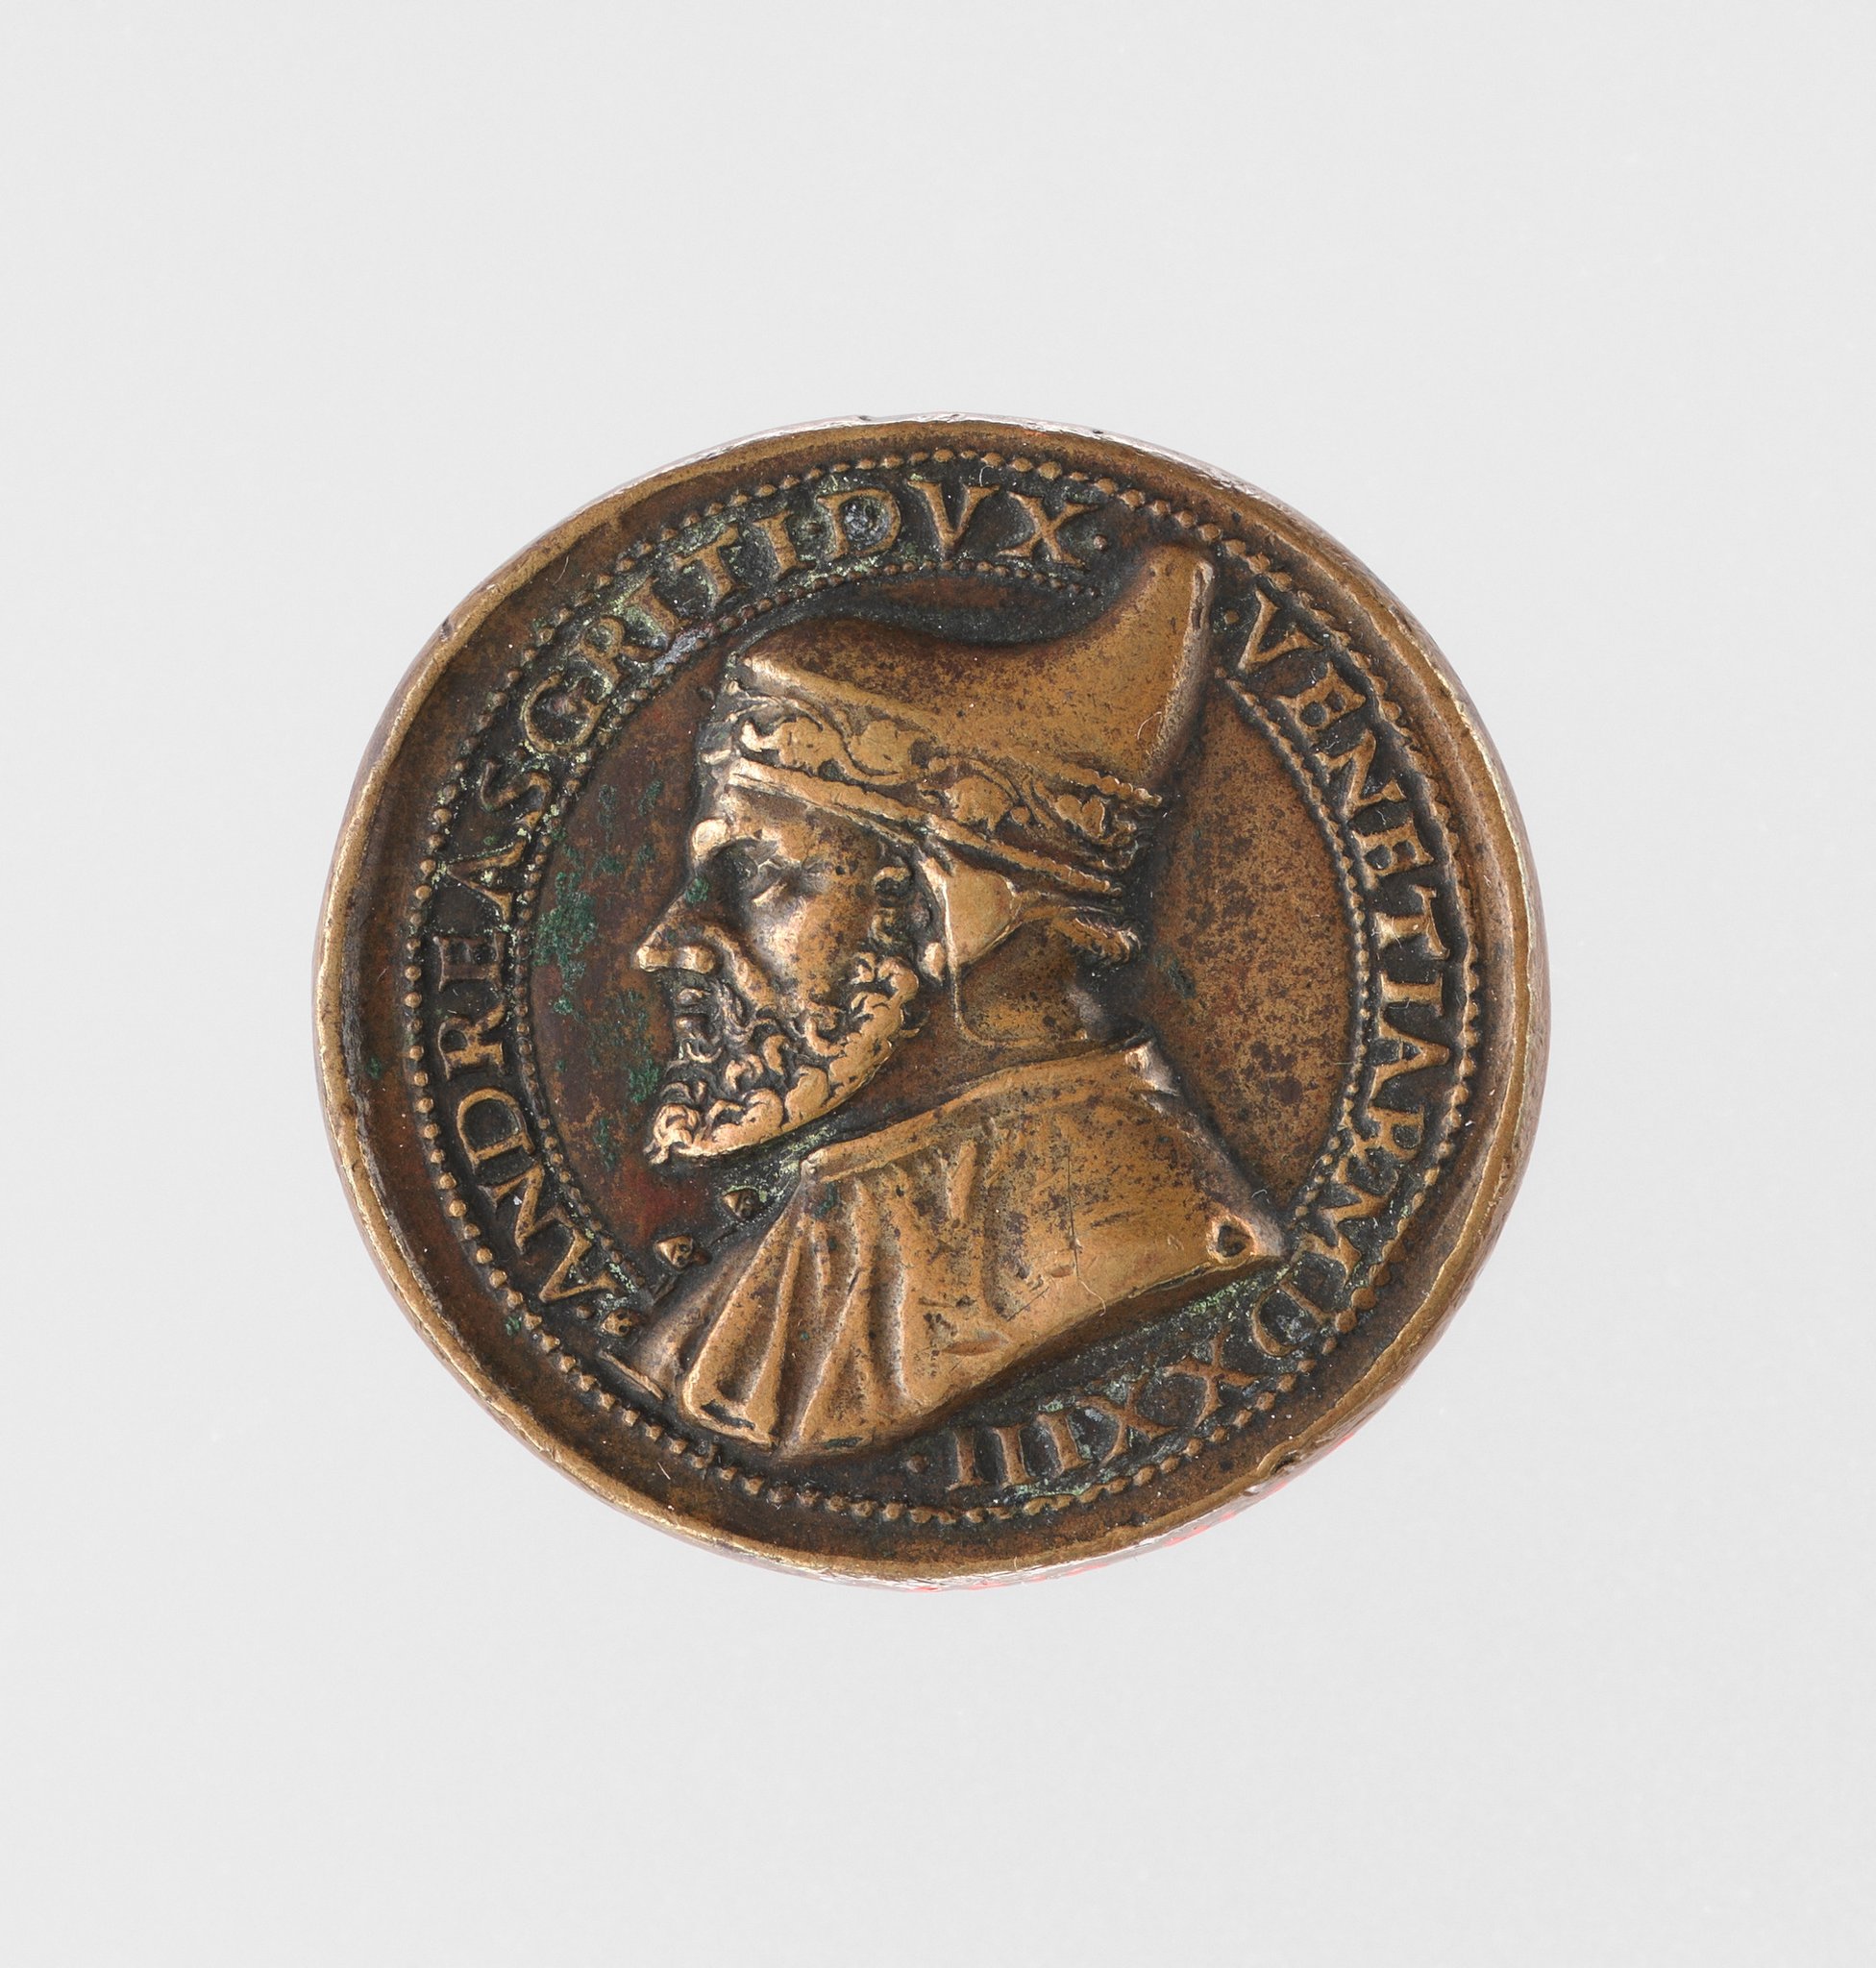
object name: medal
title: Andrea Gritti (1454-1538), Doge of Venice (from 1523)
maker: andrea spinelli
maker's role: maker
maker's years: 1508-1572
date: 1534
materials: bronze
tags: churches,men,profiles